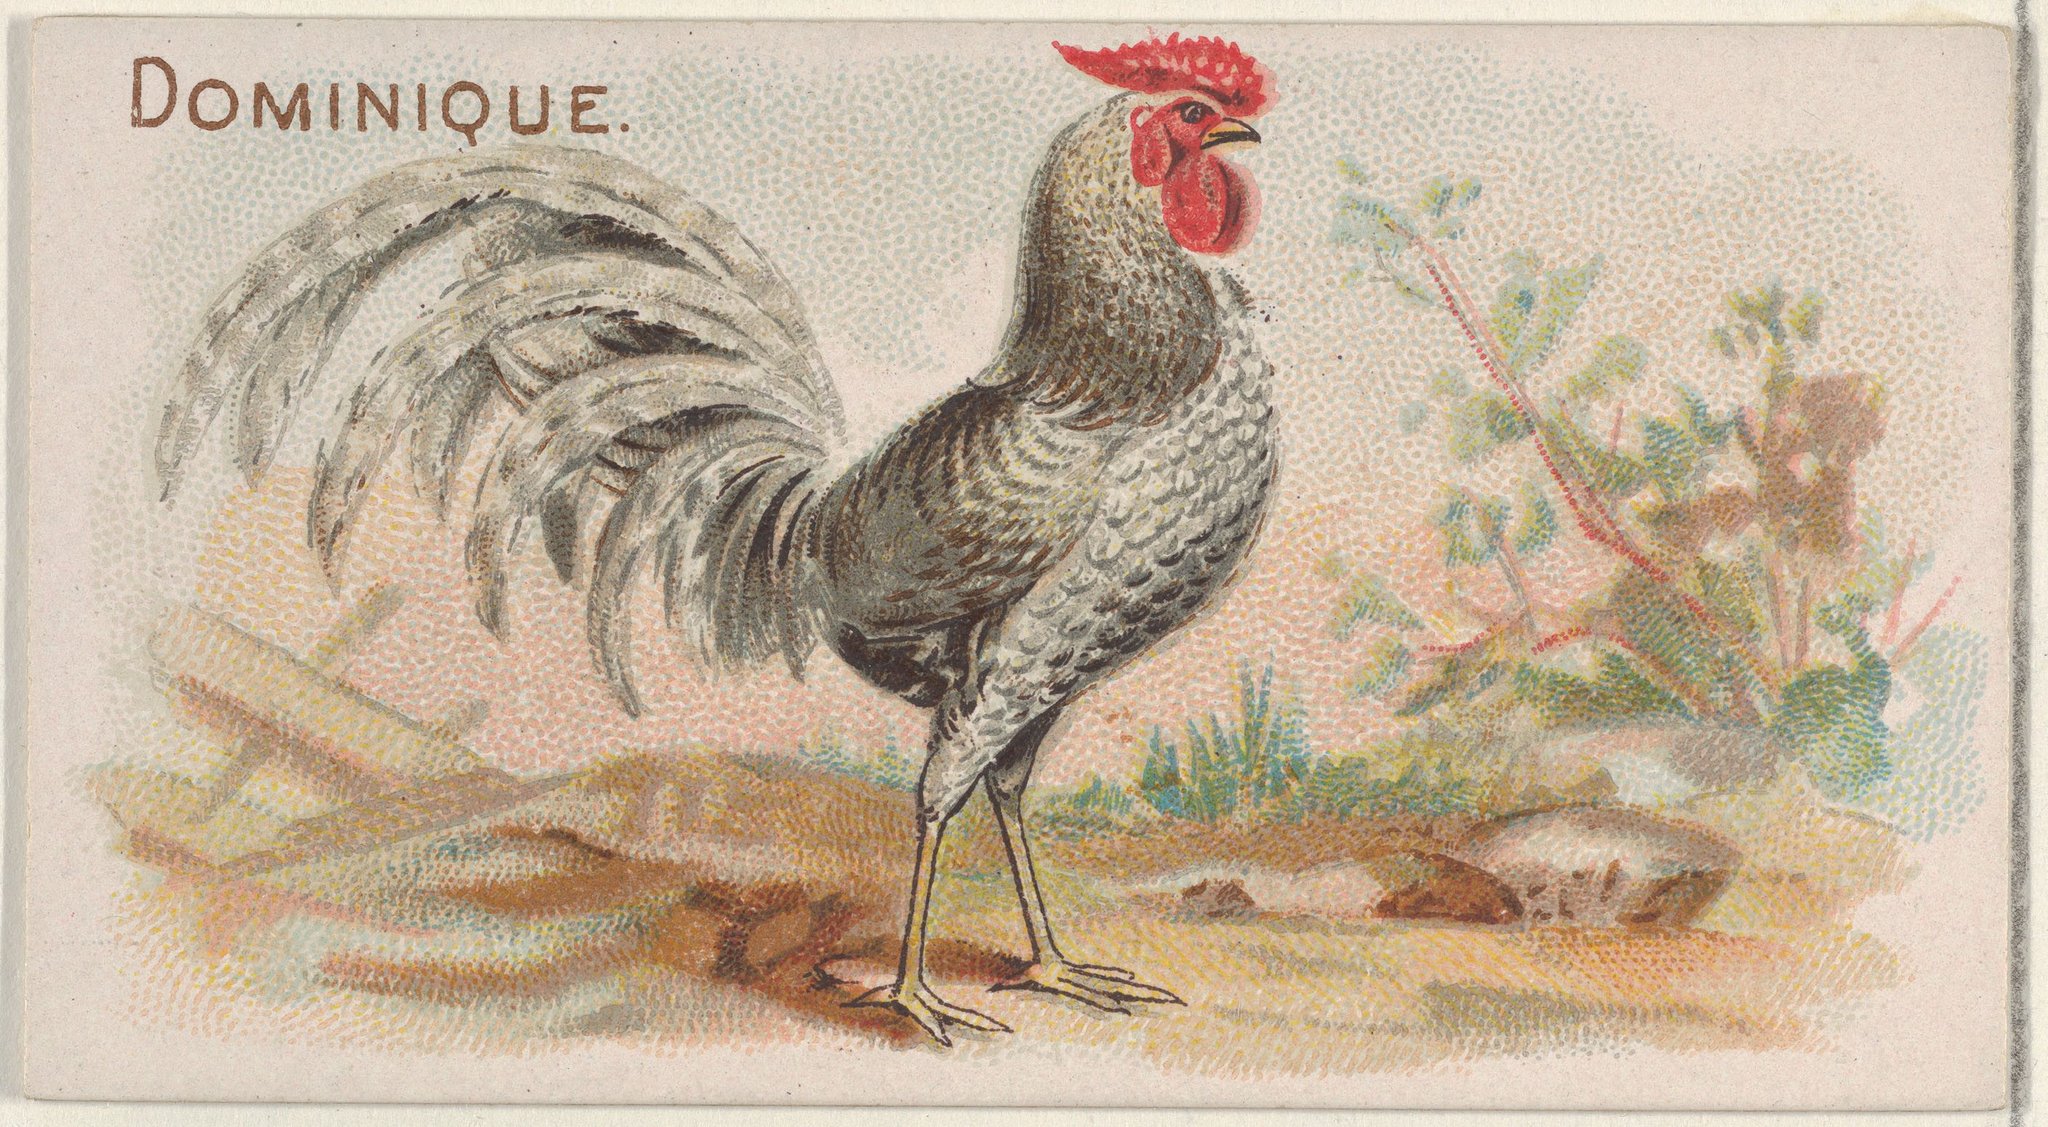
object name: print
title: Dominique, from the Prize and Game Chickens series (N20) for Allen & Ginter Cigarettes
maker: allen & ginter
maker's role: publisher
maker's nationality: american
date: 1891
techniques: color lithograph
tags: roosters